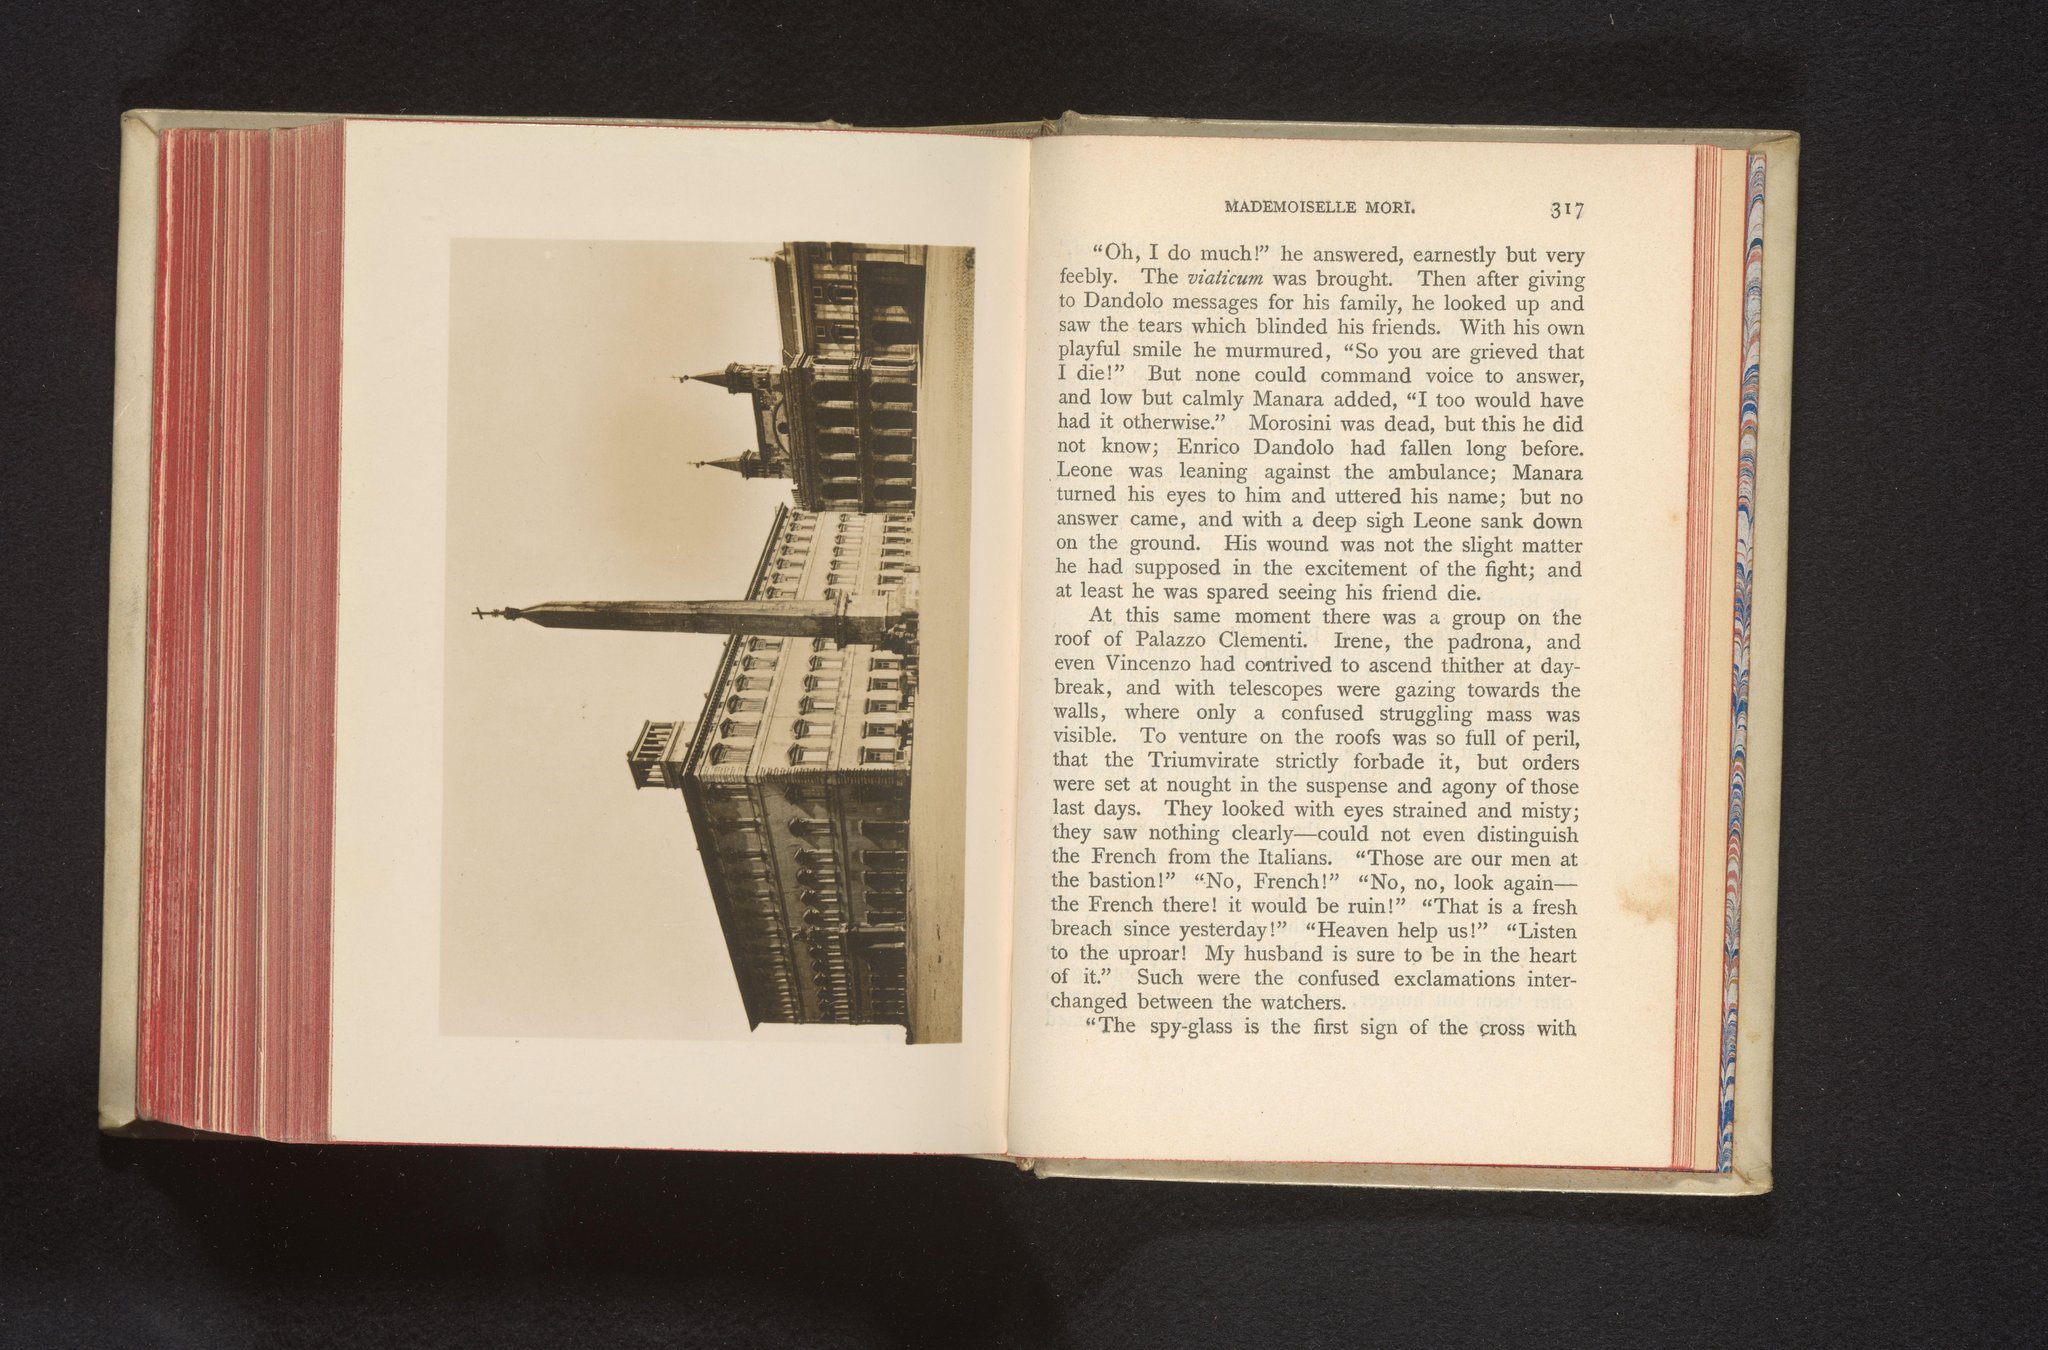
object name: photograph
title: Obelisk op het Piazza San Giovanni in Laterano te Rome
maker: Anonymous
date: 1852-1862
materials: photographic support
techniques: gelatin silver print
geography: rome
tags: square, place, circus, etc., obelisk, needle, façade (of house or building)